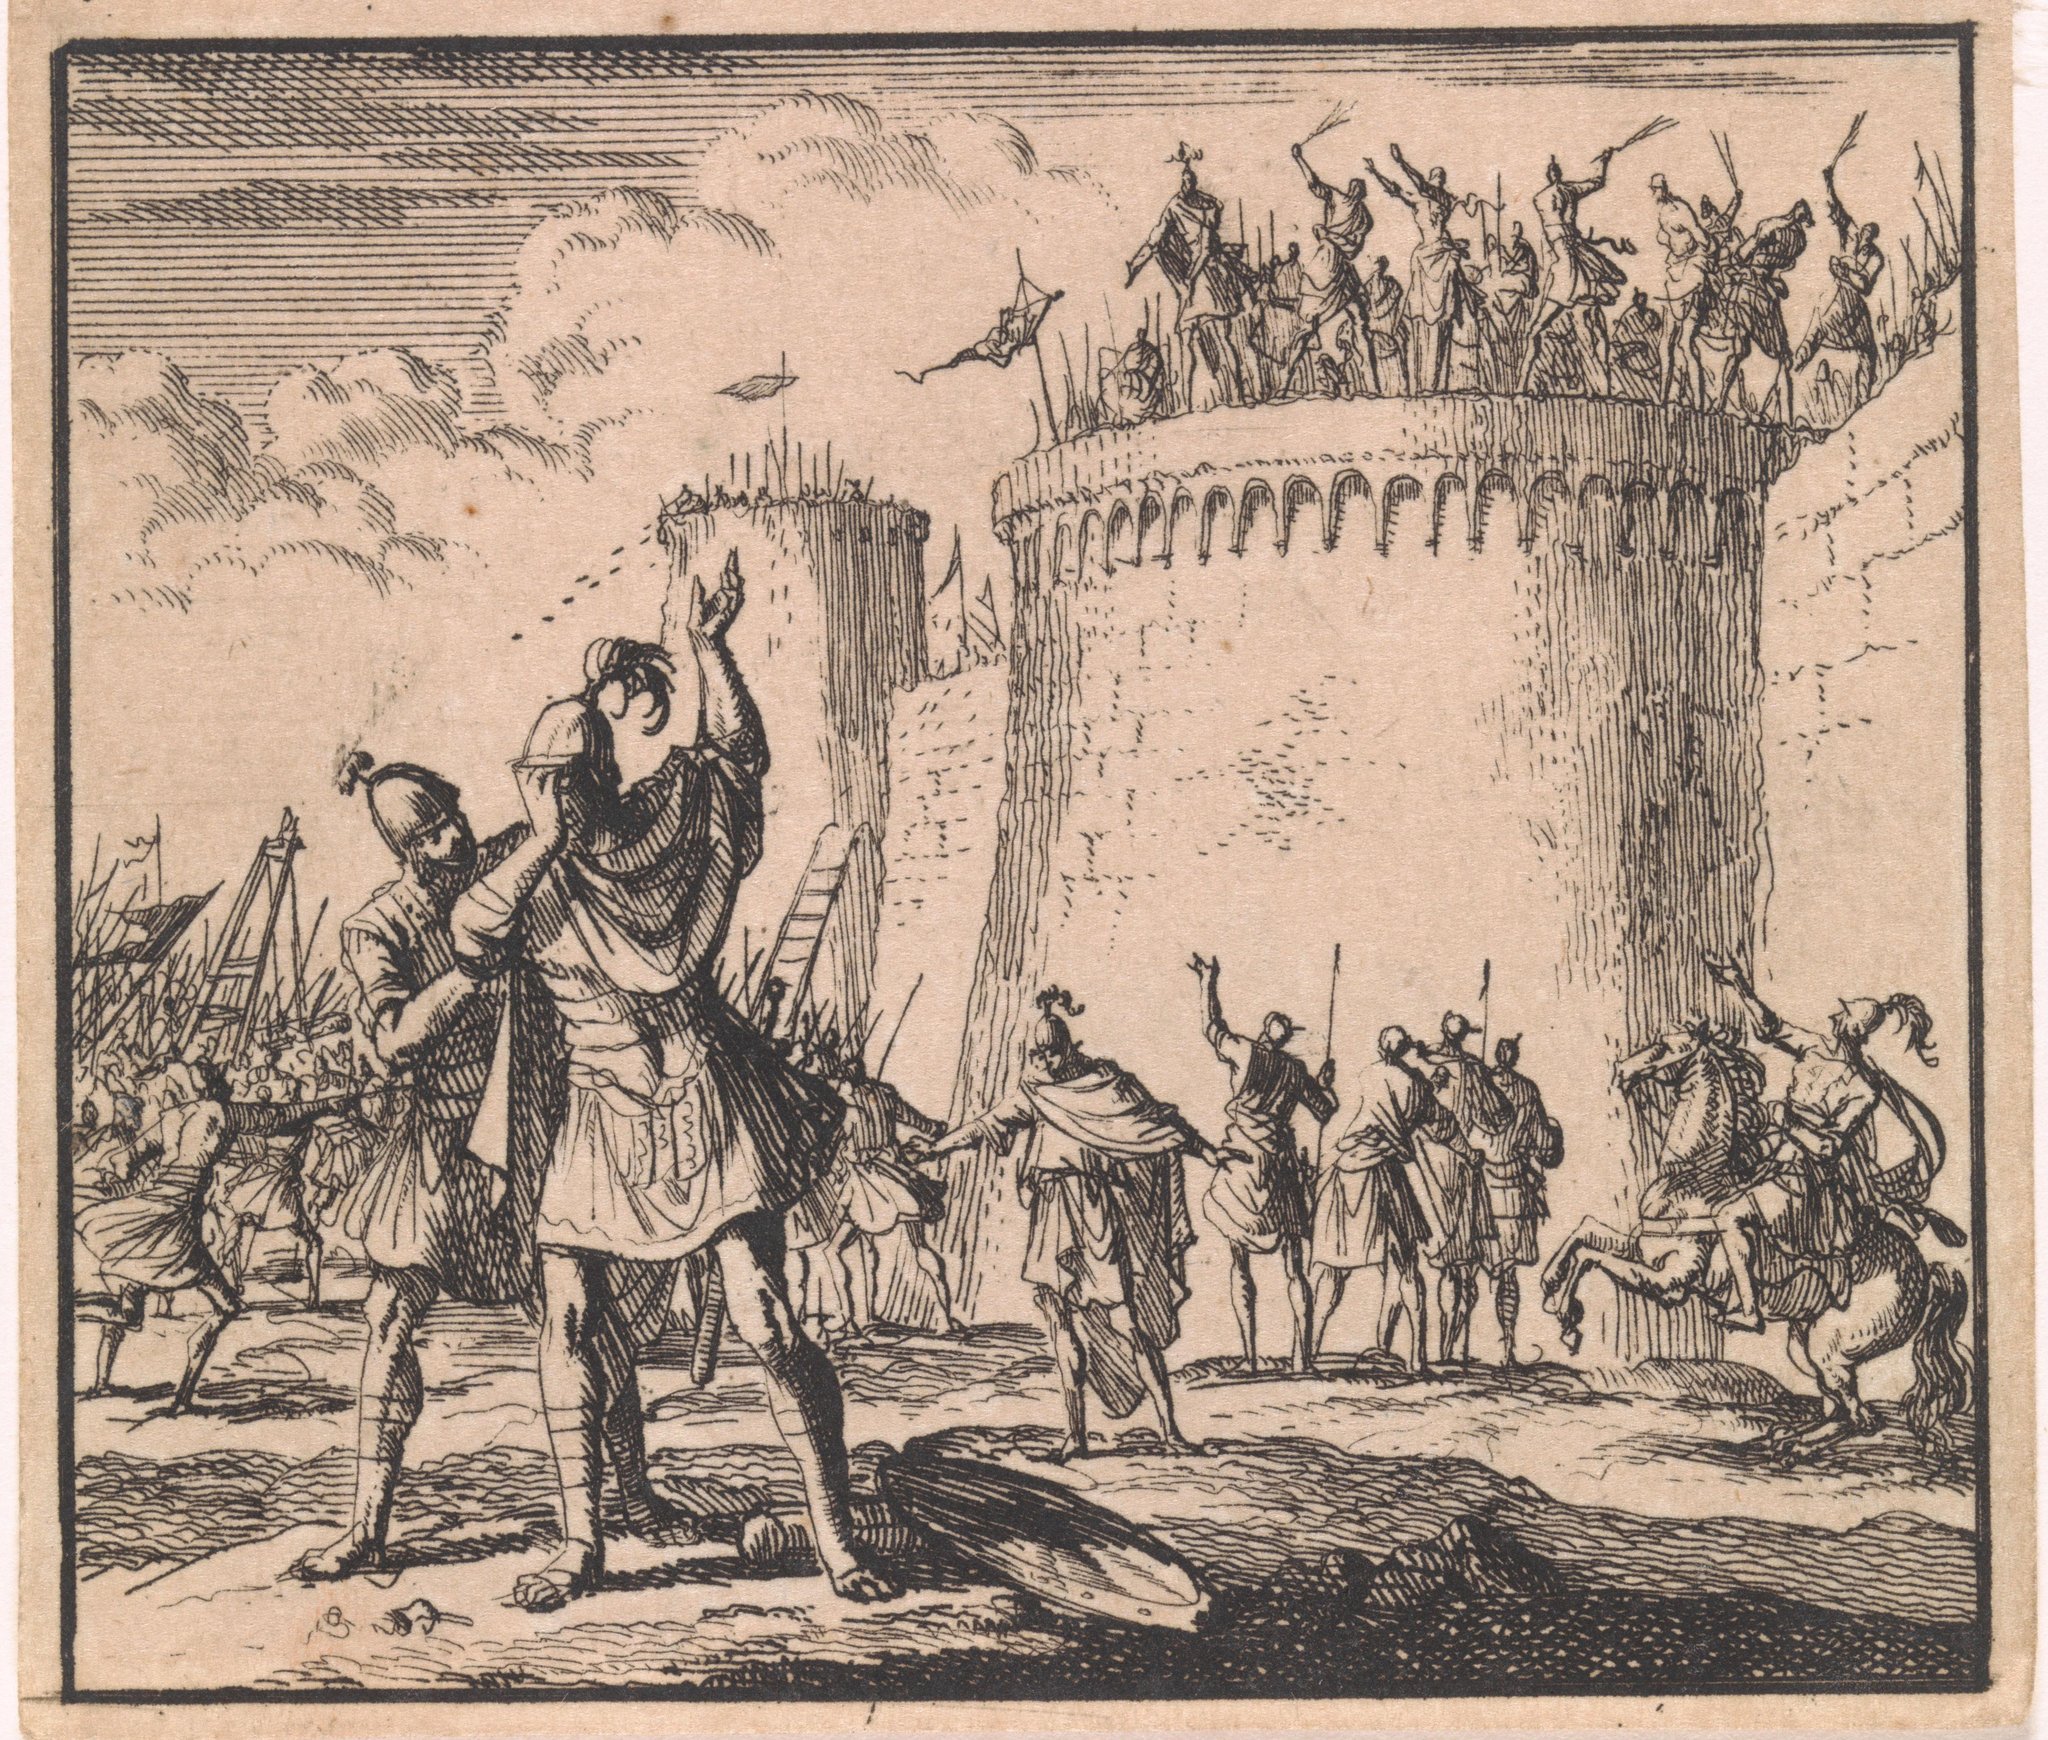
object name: print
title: Johannes Hyrcanus bedekt zijn gelaat tijdens de belegering van Dagon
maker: jan luyken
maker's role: draughtsman, print maker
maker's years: 1649-1712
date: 1698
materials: paper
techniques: etching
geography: amsterdam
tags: john hyrcanus appointed leader of the maccabees (1 maccabees 16:19-22)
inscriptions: collector's mark: Lugt 2228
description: Proefdruk van illustratie uit: Josephus, Flavius. XX. boeken van de oude geschiedenissen der joden, 4 delen. Amsterdam: Barent Visscher, Willem de Coup, Willem van Lamsveld, Andries van Damme, 1698, dl. II.